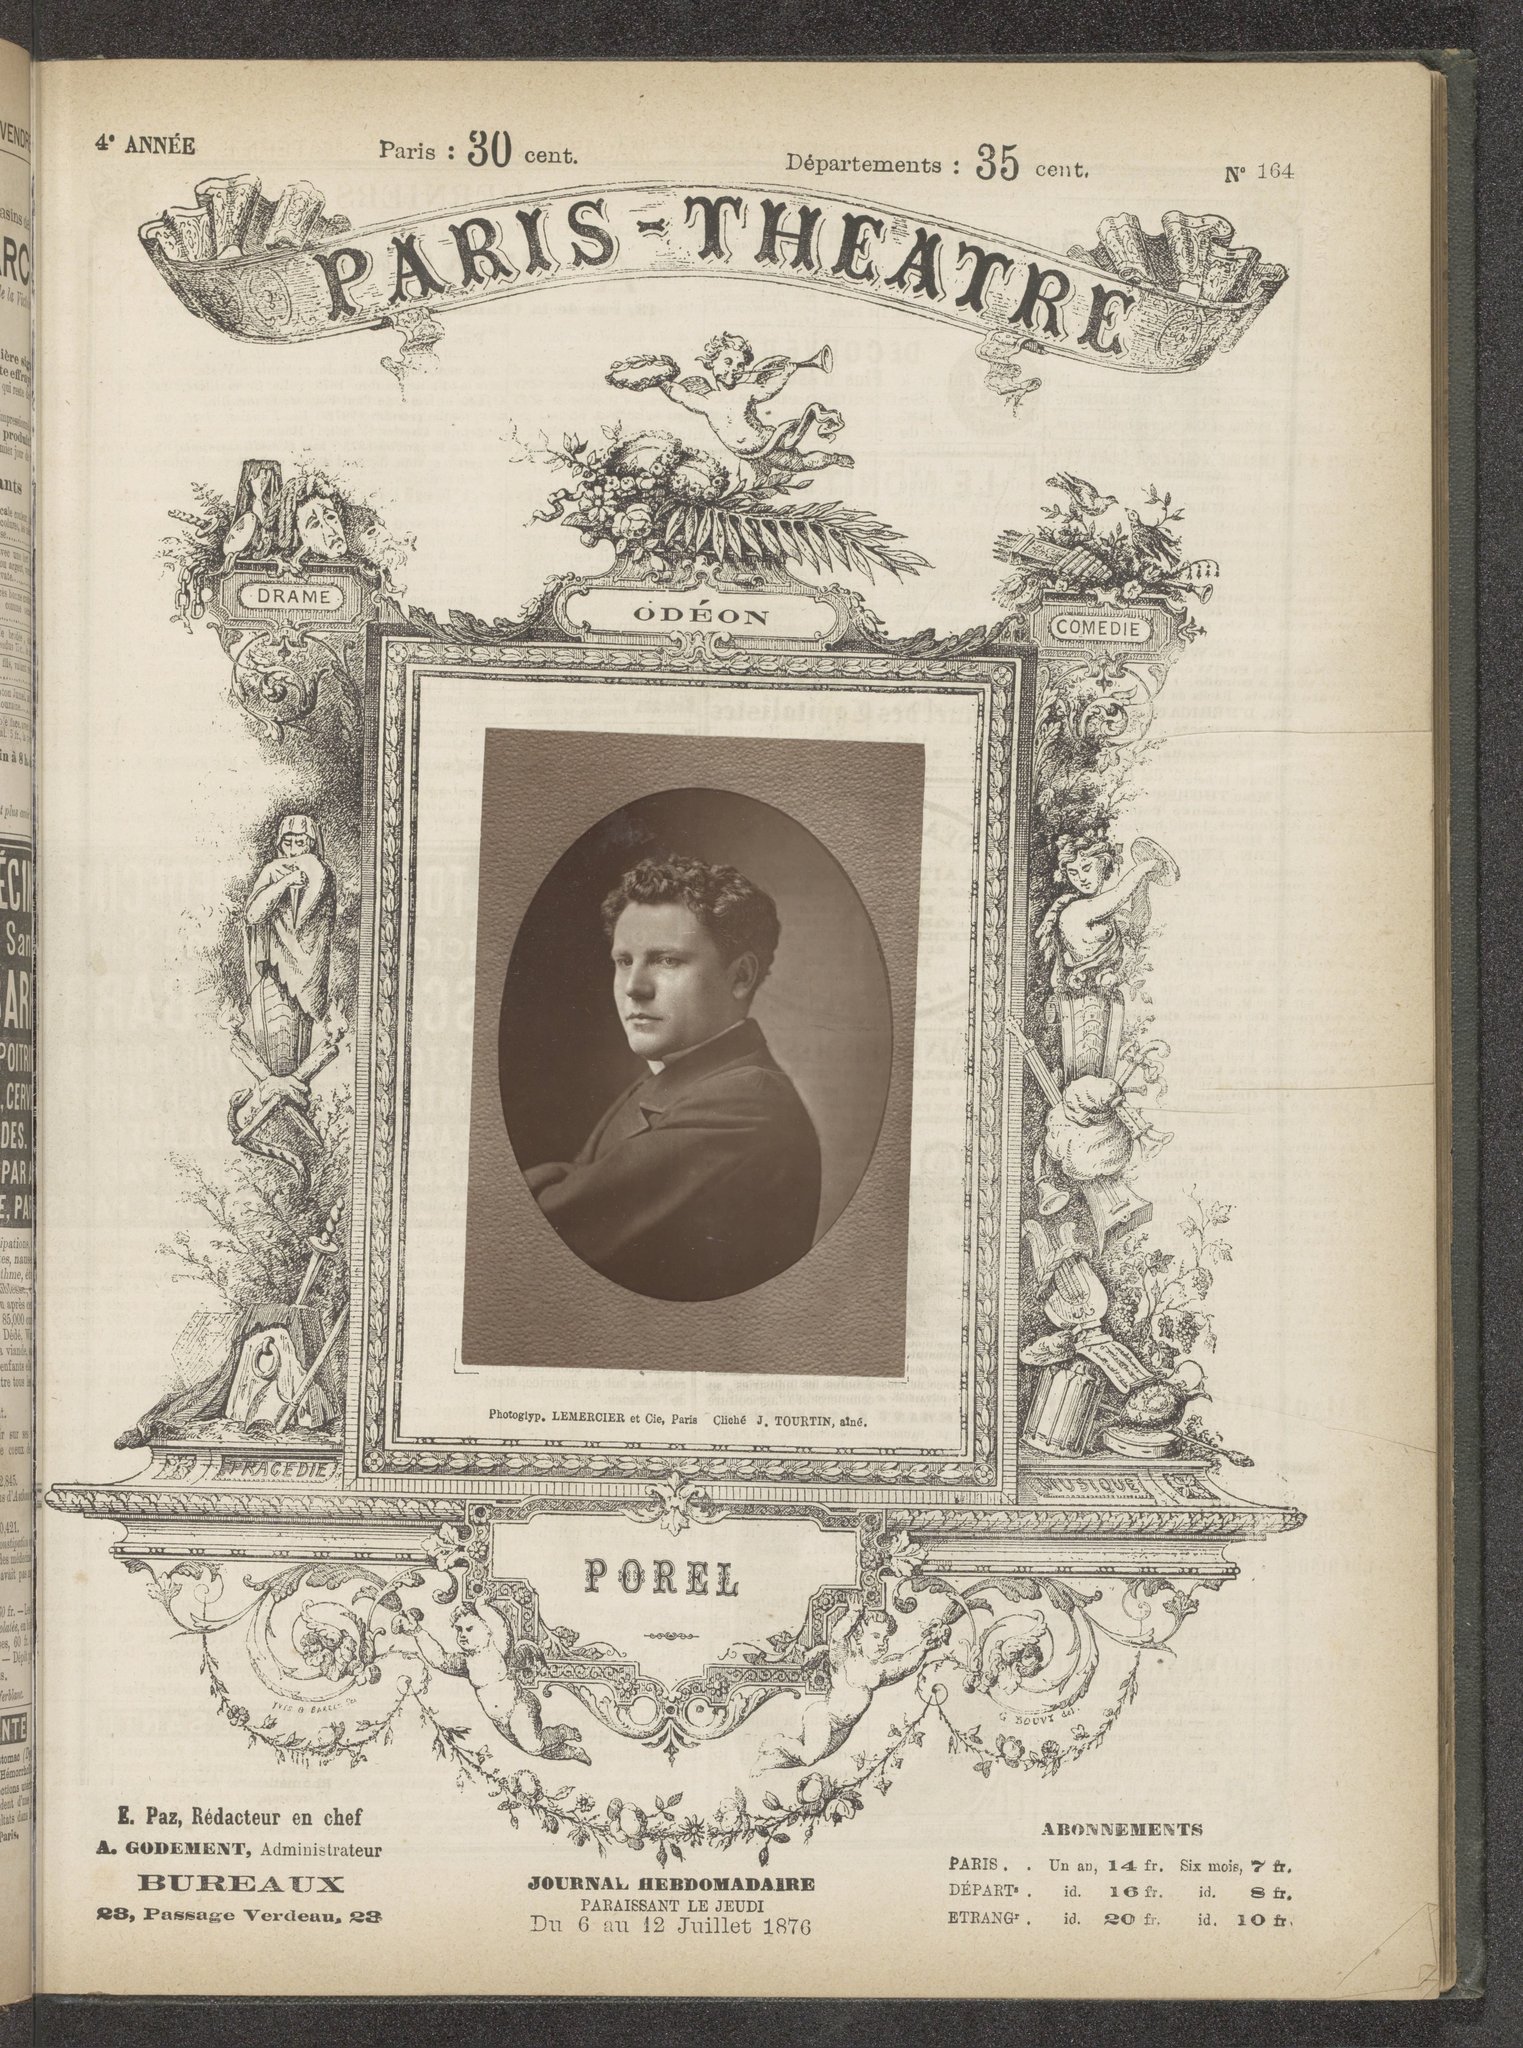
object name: photomechanical print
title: Porel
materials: paper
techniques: woodburytype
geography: france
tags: portrait of actor, actress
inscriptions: number: ‘No 164’, inscription: ‘Journal hebdomadaire paraissant le jeudi Du 6 au 12 Juillet 1876’